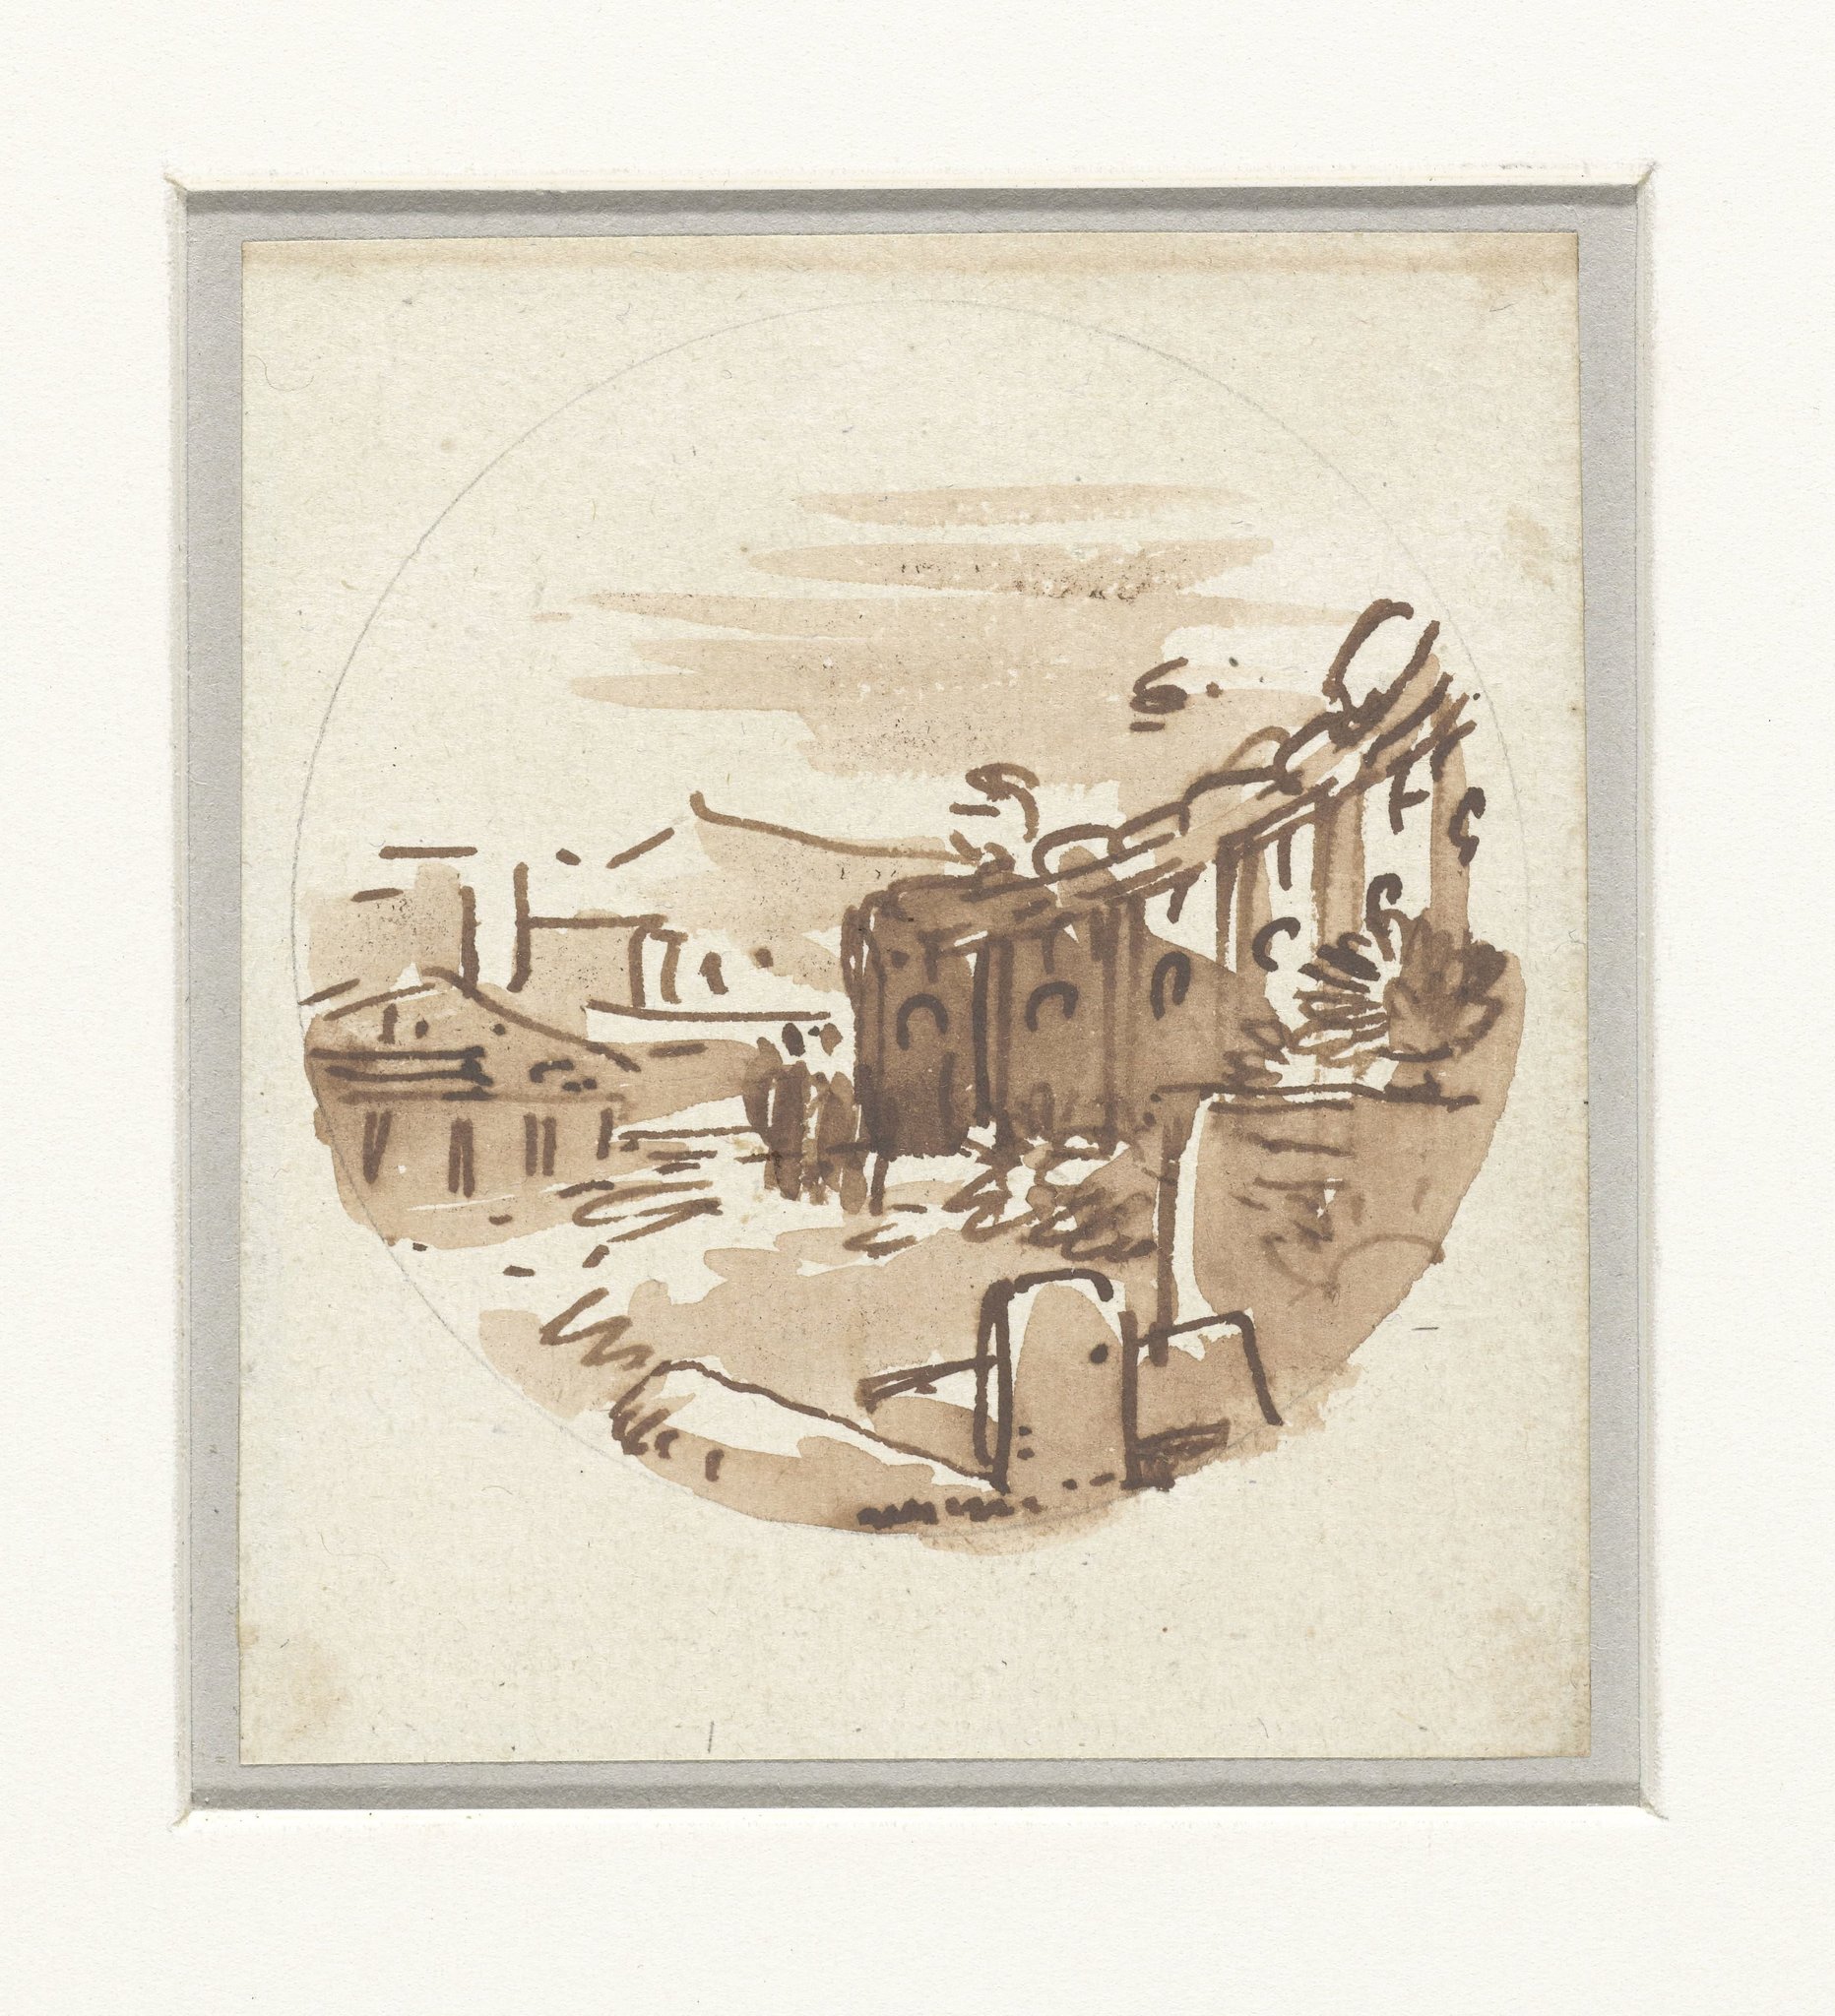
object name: drawing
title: Vluchtige schets van klassieke gebouwen, een tempel en een portiek in een gebogen wand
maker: victor jean nicolle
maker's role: draughtsman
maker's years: 1754-1826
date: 1787-1811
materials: ink, paper, pencil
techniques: brush, pen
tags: monumental adornments (in city)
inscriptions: collector's mark, verso, on the mount, lower centre: Lugt 2228